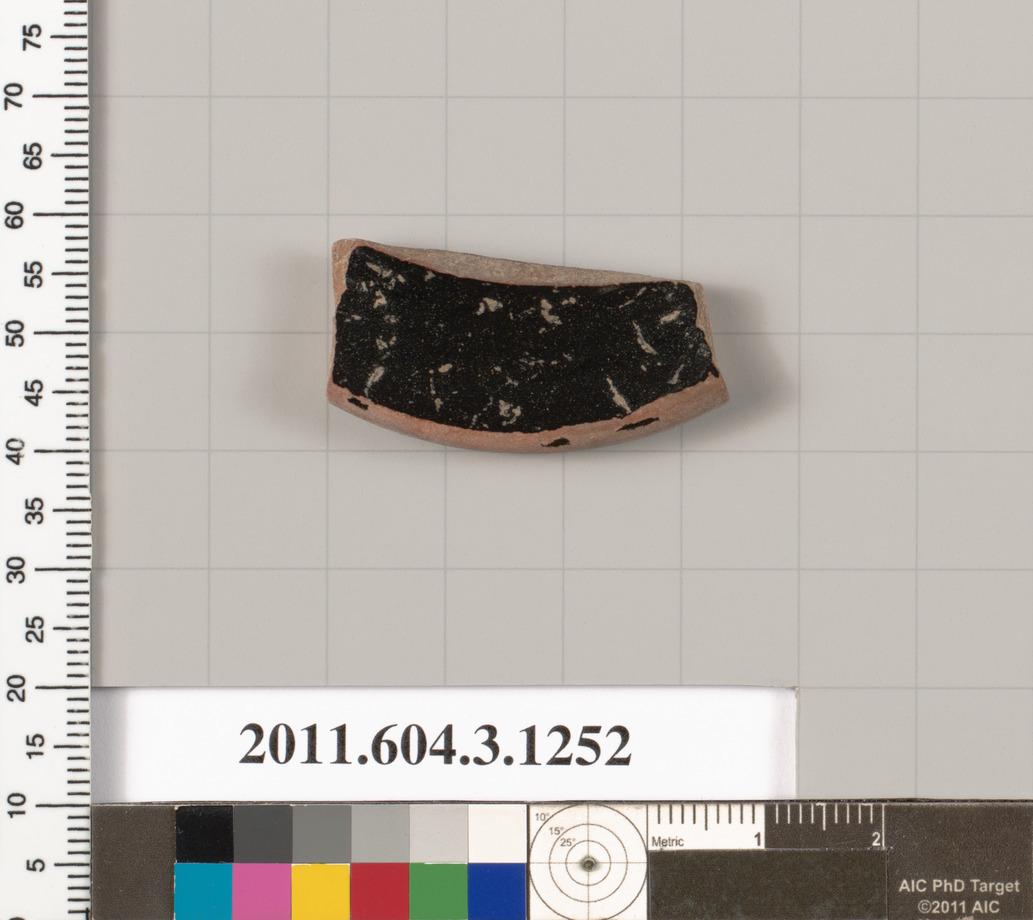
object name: kyathos fragment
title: Terracotta fragment of a kyathos (cup-shaped ladle)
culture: greek, attic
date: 534-468 BCE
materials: terracotta